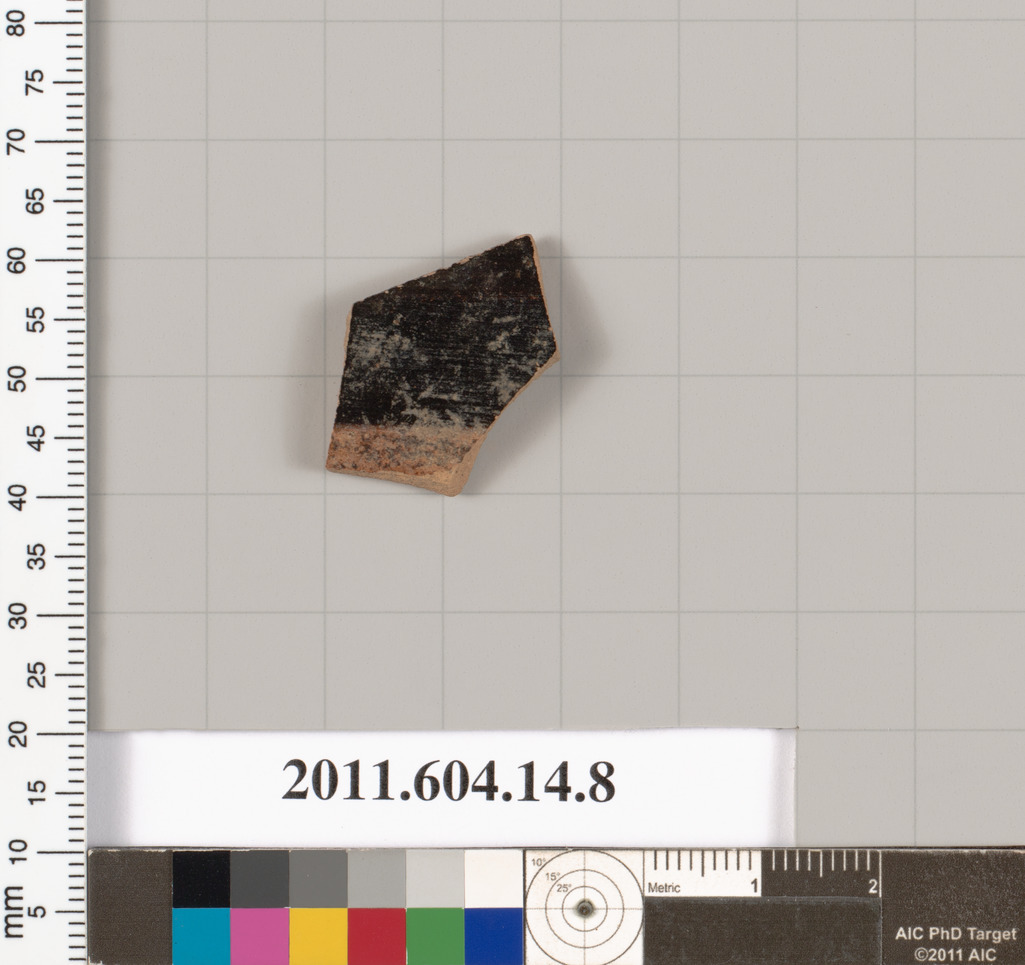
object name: kylix fragment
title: Terracotta fragment of a kylix?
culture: unknown fabric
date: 600-501 BCE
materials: terracotta